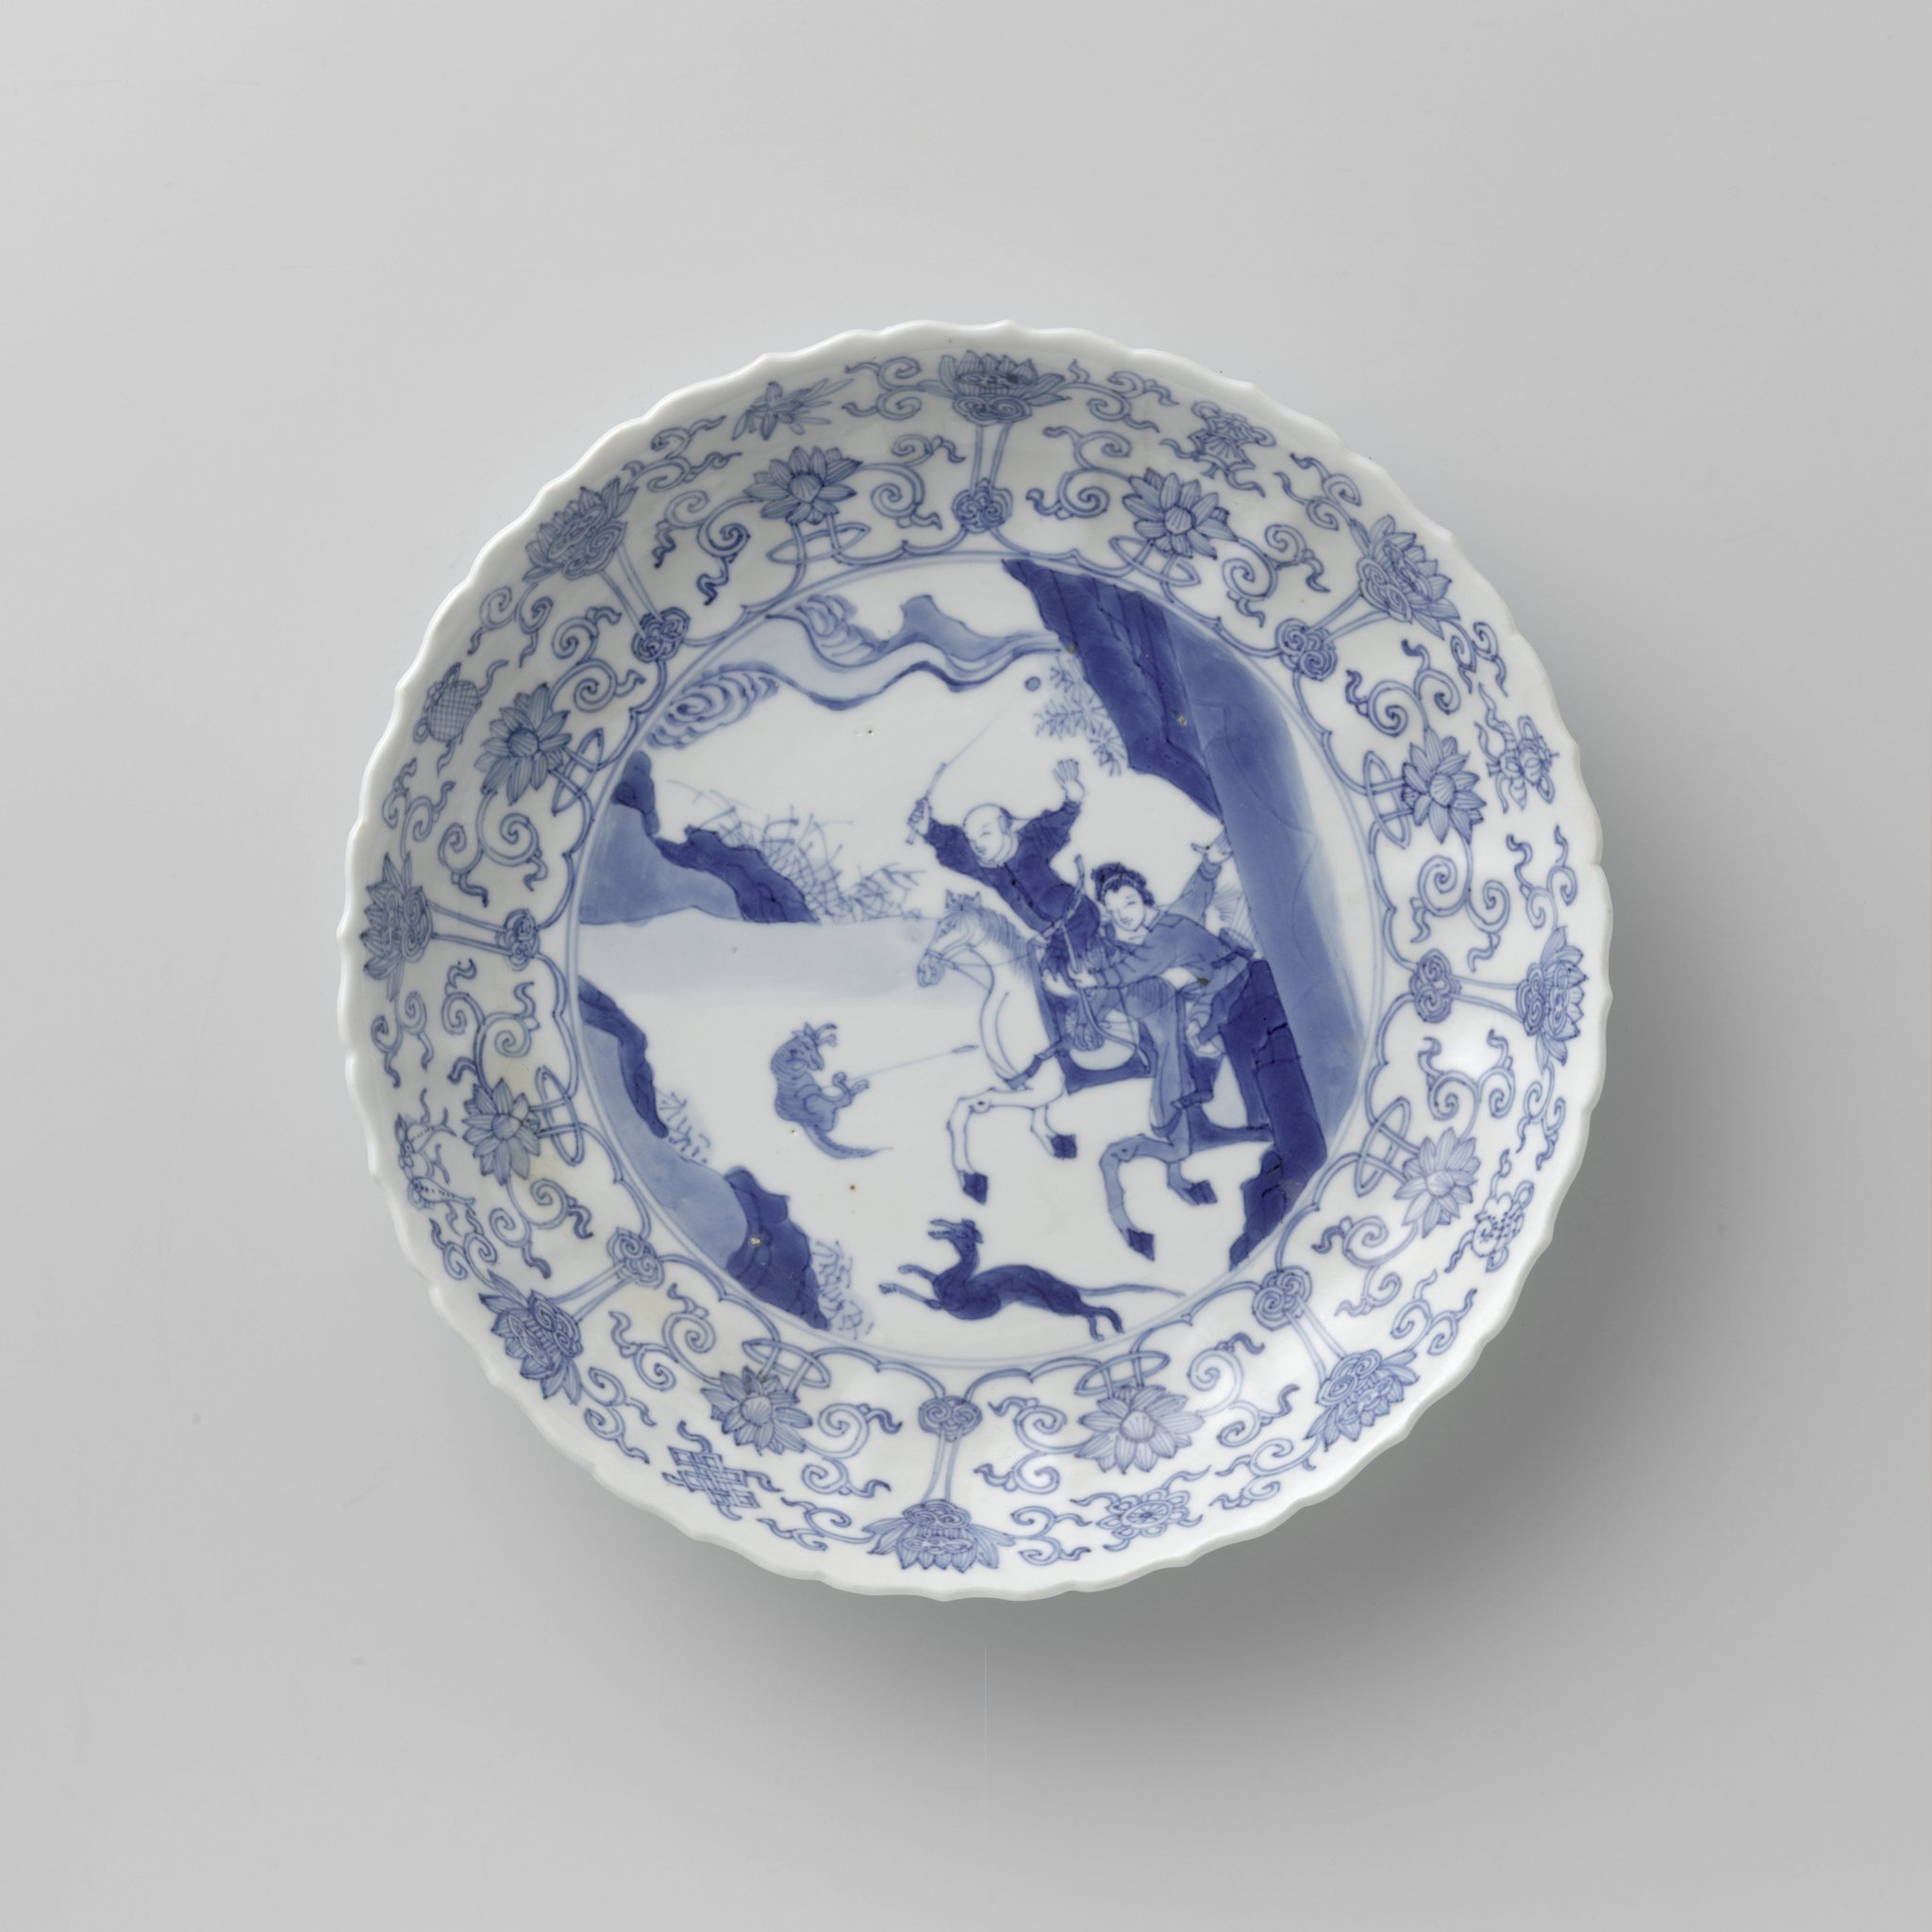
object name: dish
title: Saucer-dish with hunting scene, lotus scrolls and auspicious symbols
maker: Anonymous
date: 1700-1724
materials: cobalt, glaze, paint, porcelain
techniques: firing, forming, turning, vitrification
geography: china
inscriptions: mark: ‘大 明 成 化 年 製 dà míng Chéng huà nián zhì’